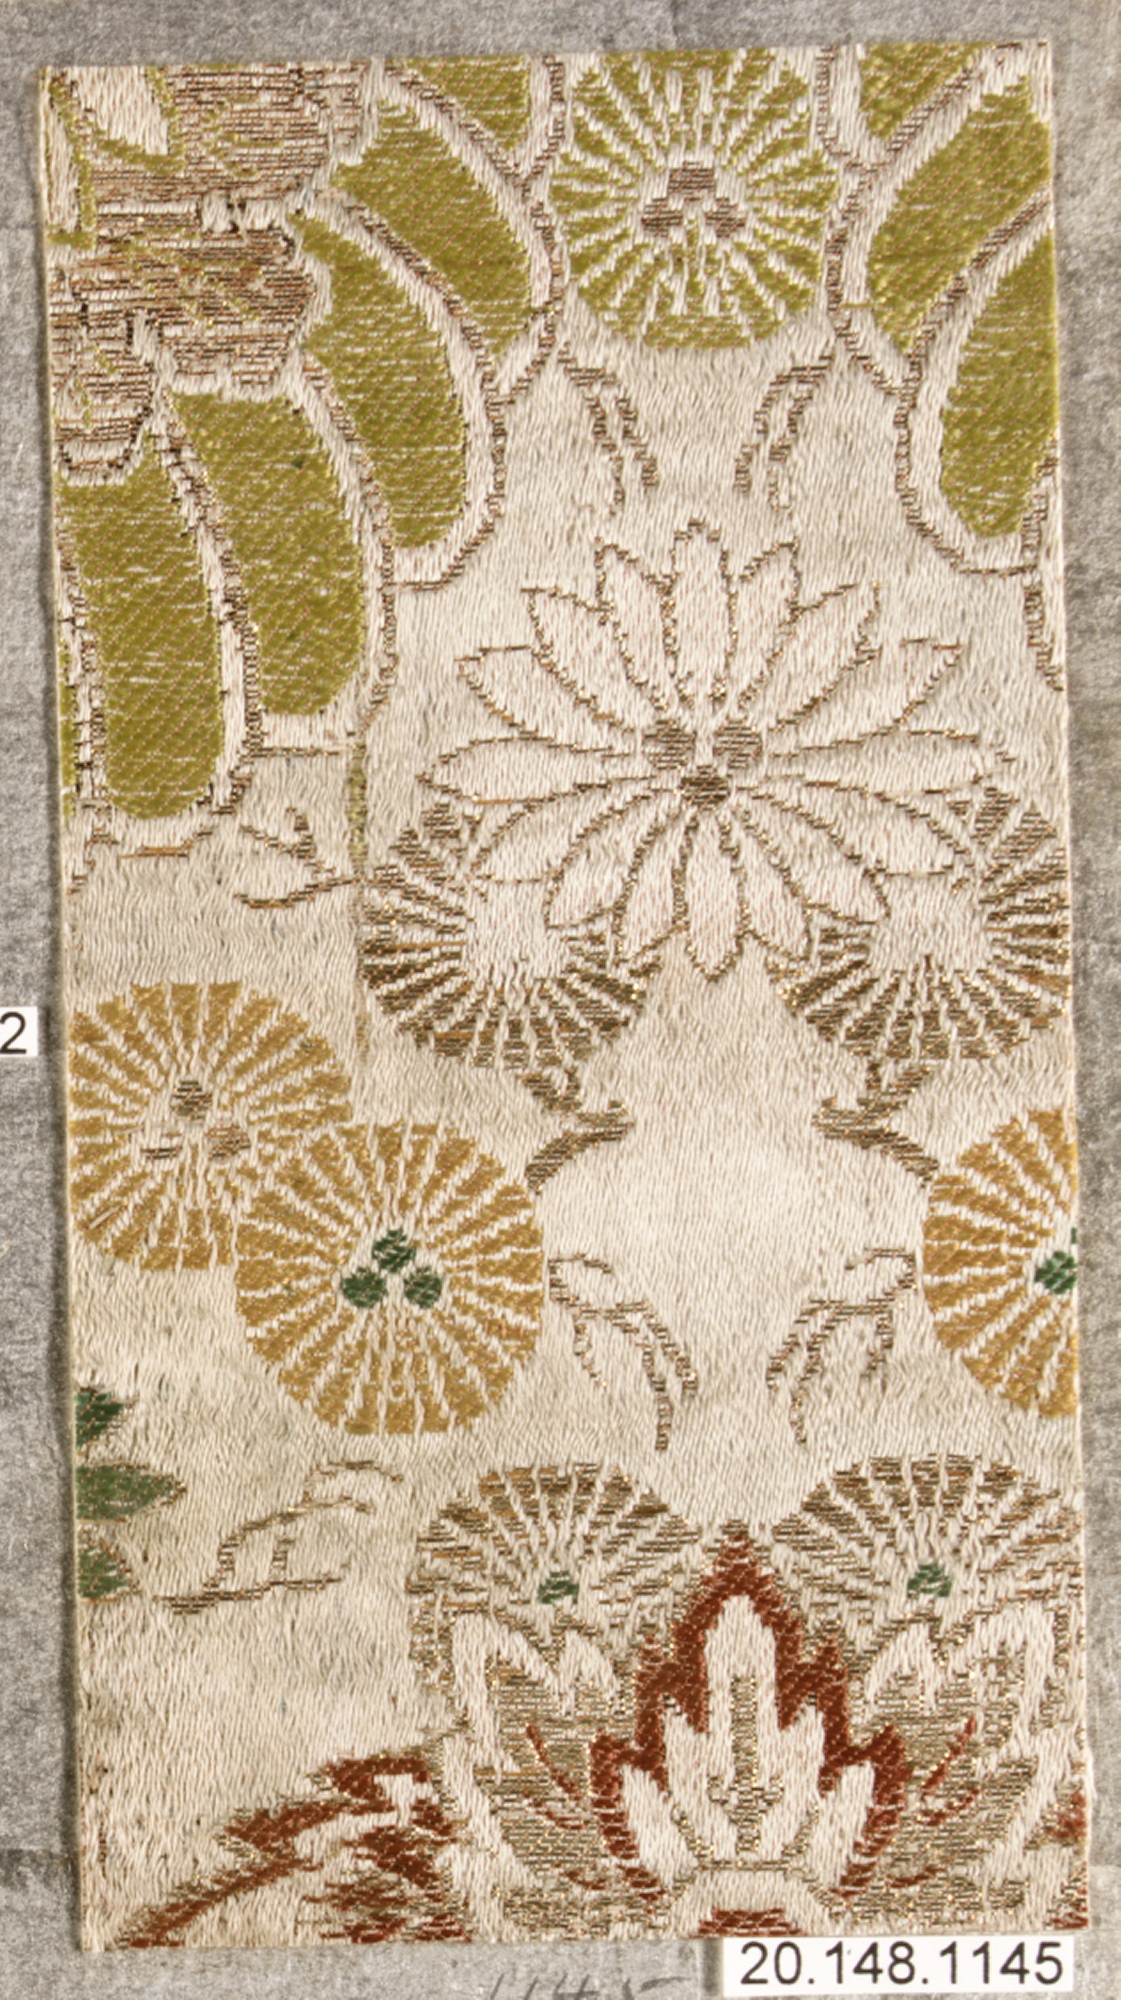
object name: piece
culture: japanese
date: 1701-1800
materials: silk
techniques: compound weave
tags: flowers,leaves